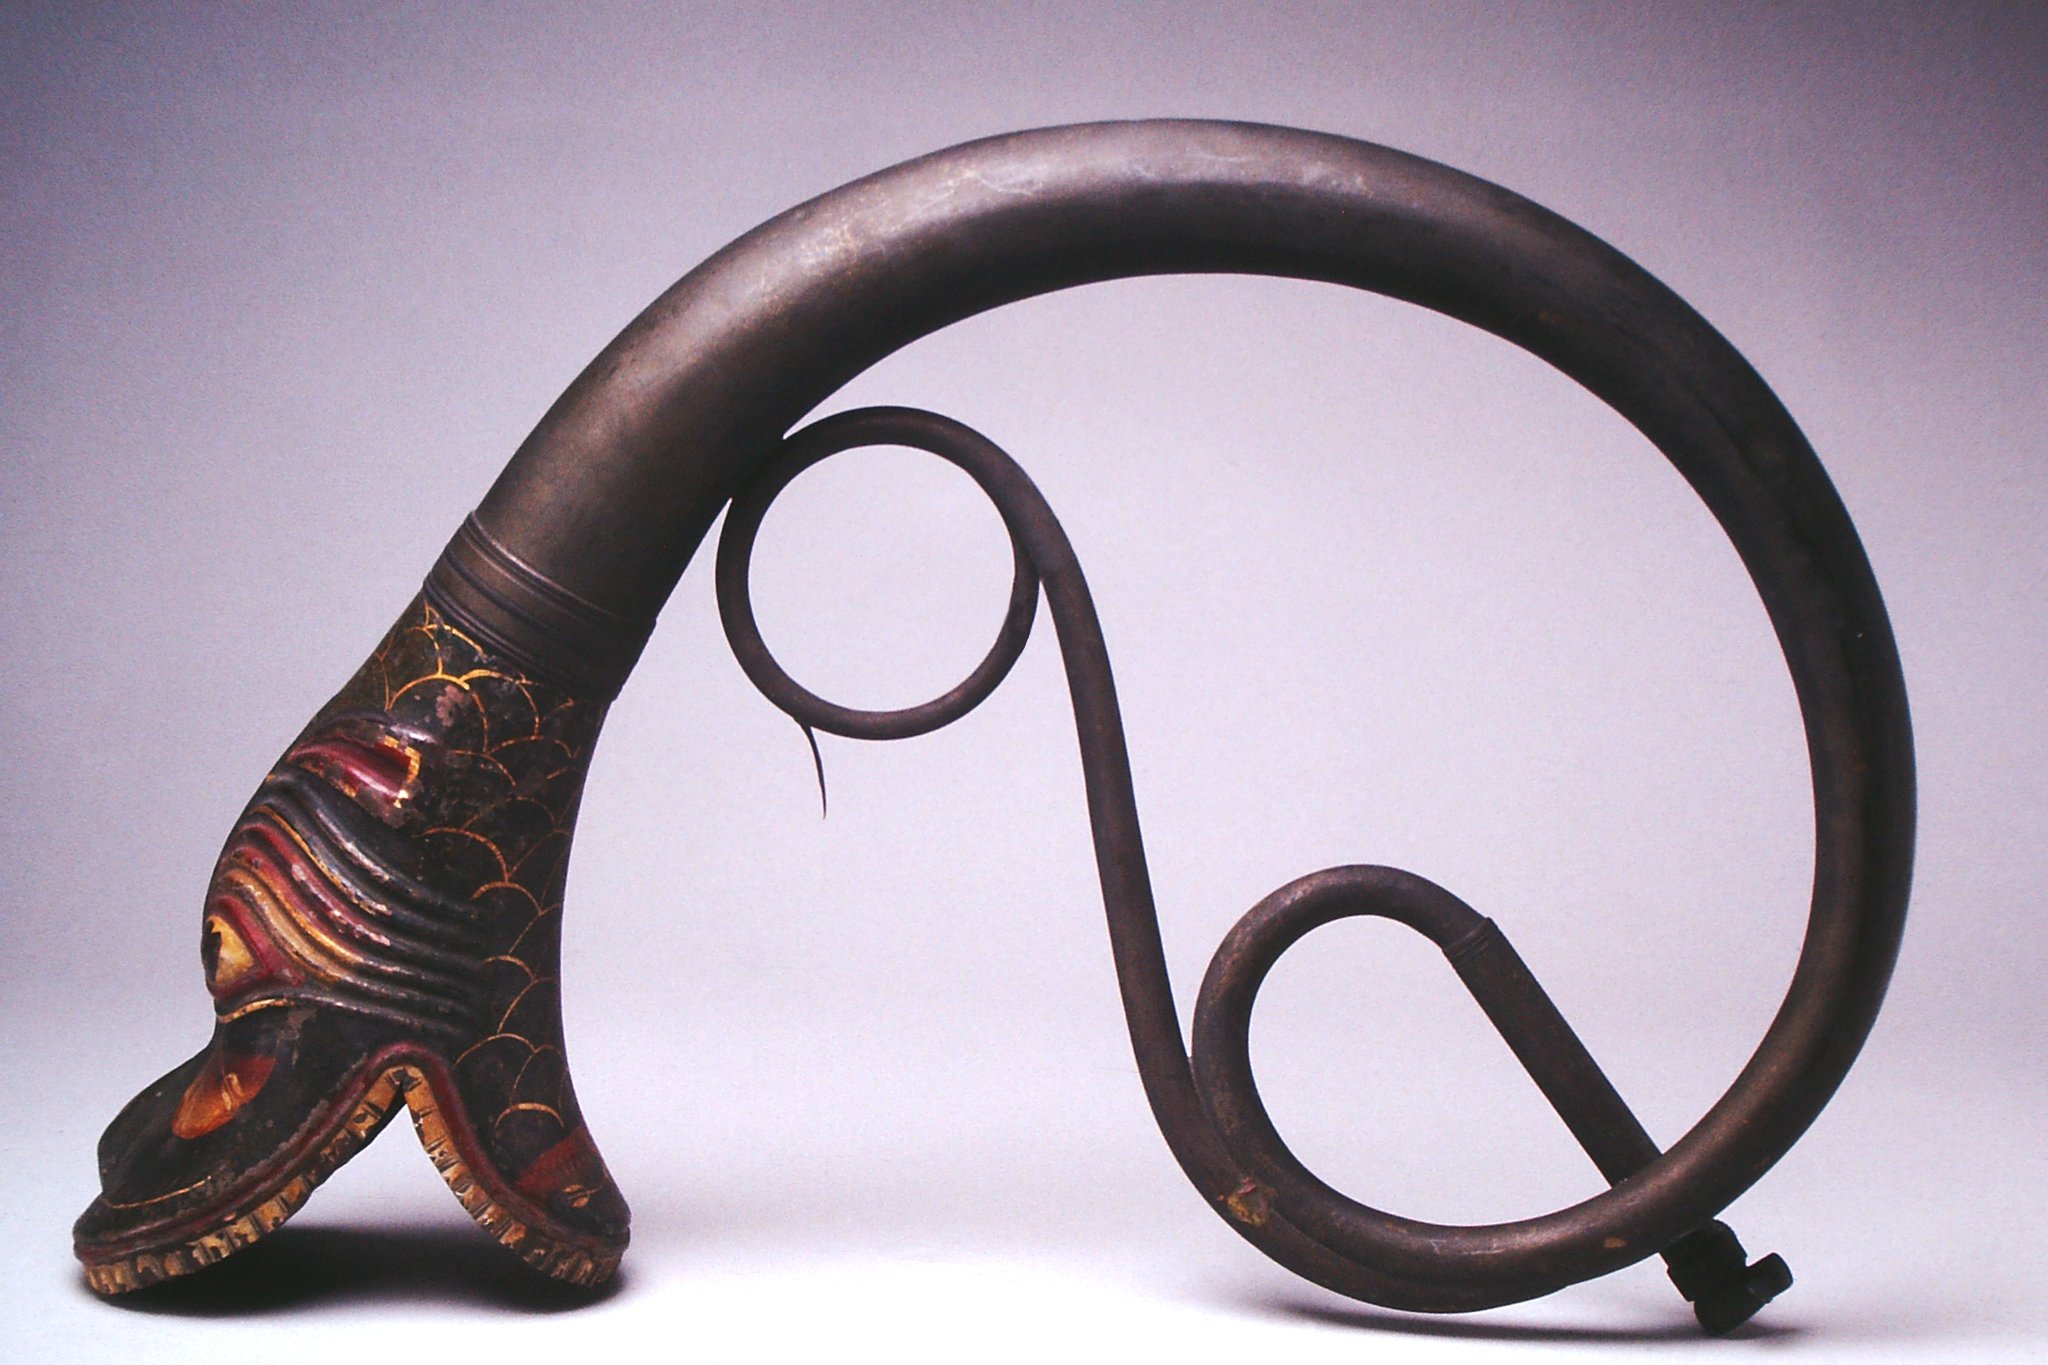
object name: horn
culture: german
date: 1801-1900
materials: brass, leather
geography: germany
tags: animals